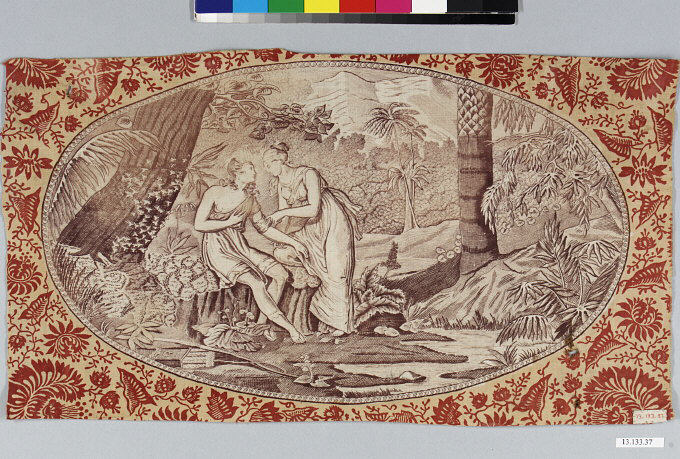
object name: furnishing textile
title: Atala and Chactas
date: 1801-1833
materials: cotton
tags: men,women,trees